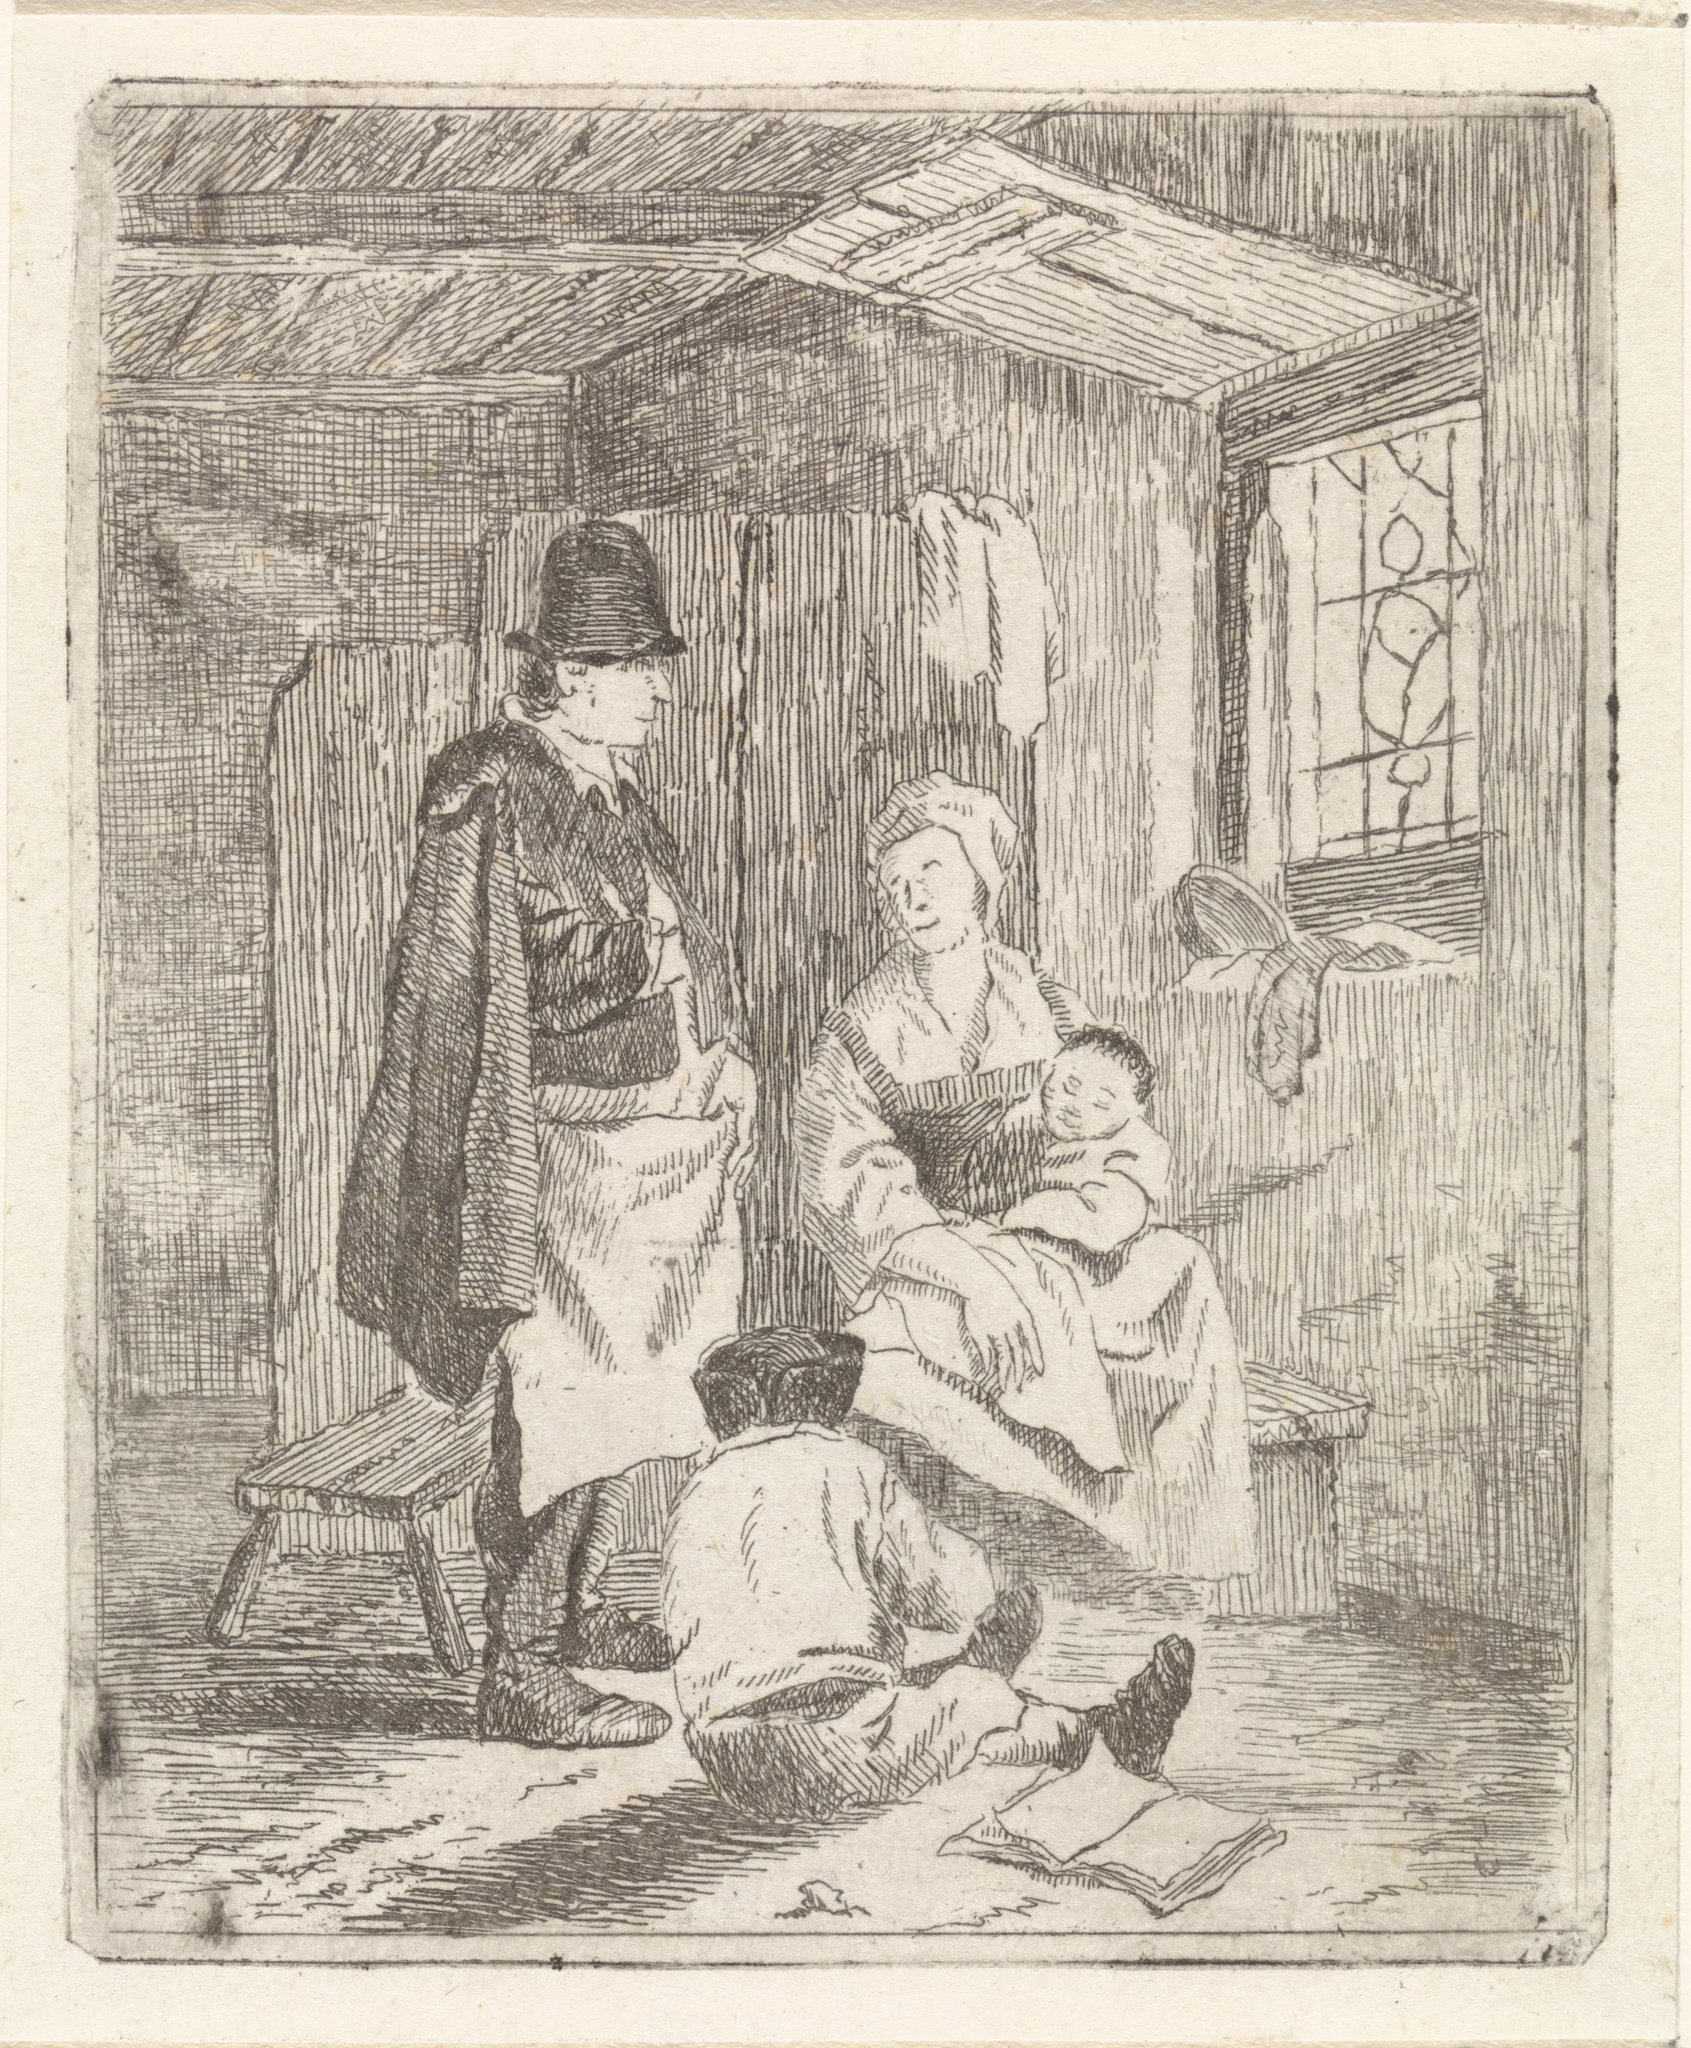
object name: print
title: Familie in interieur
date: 1739-1851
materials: paper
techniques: etching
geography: leiden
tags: family life at home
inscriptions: collector's mark: Lugt 240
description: Interieur met man en vrouw met kind op schoot. Bij hen twee kinderen, van wie er een in een boek kijkt.